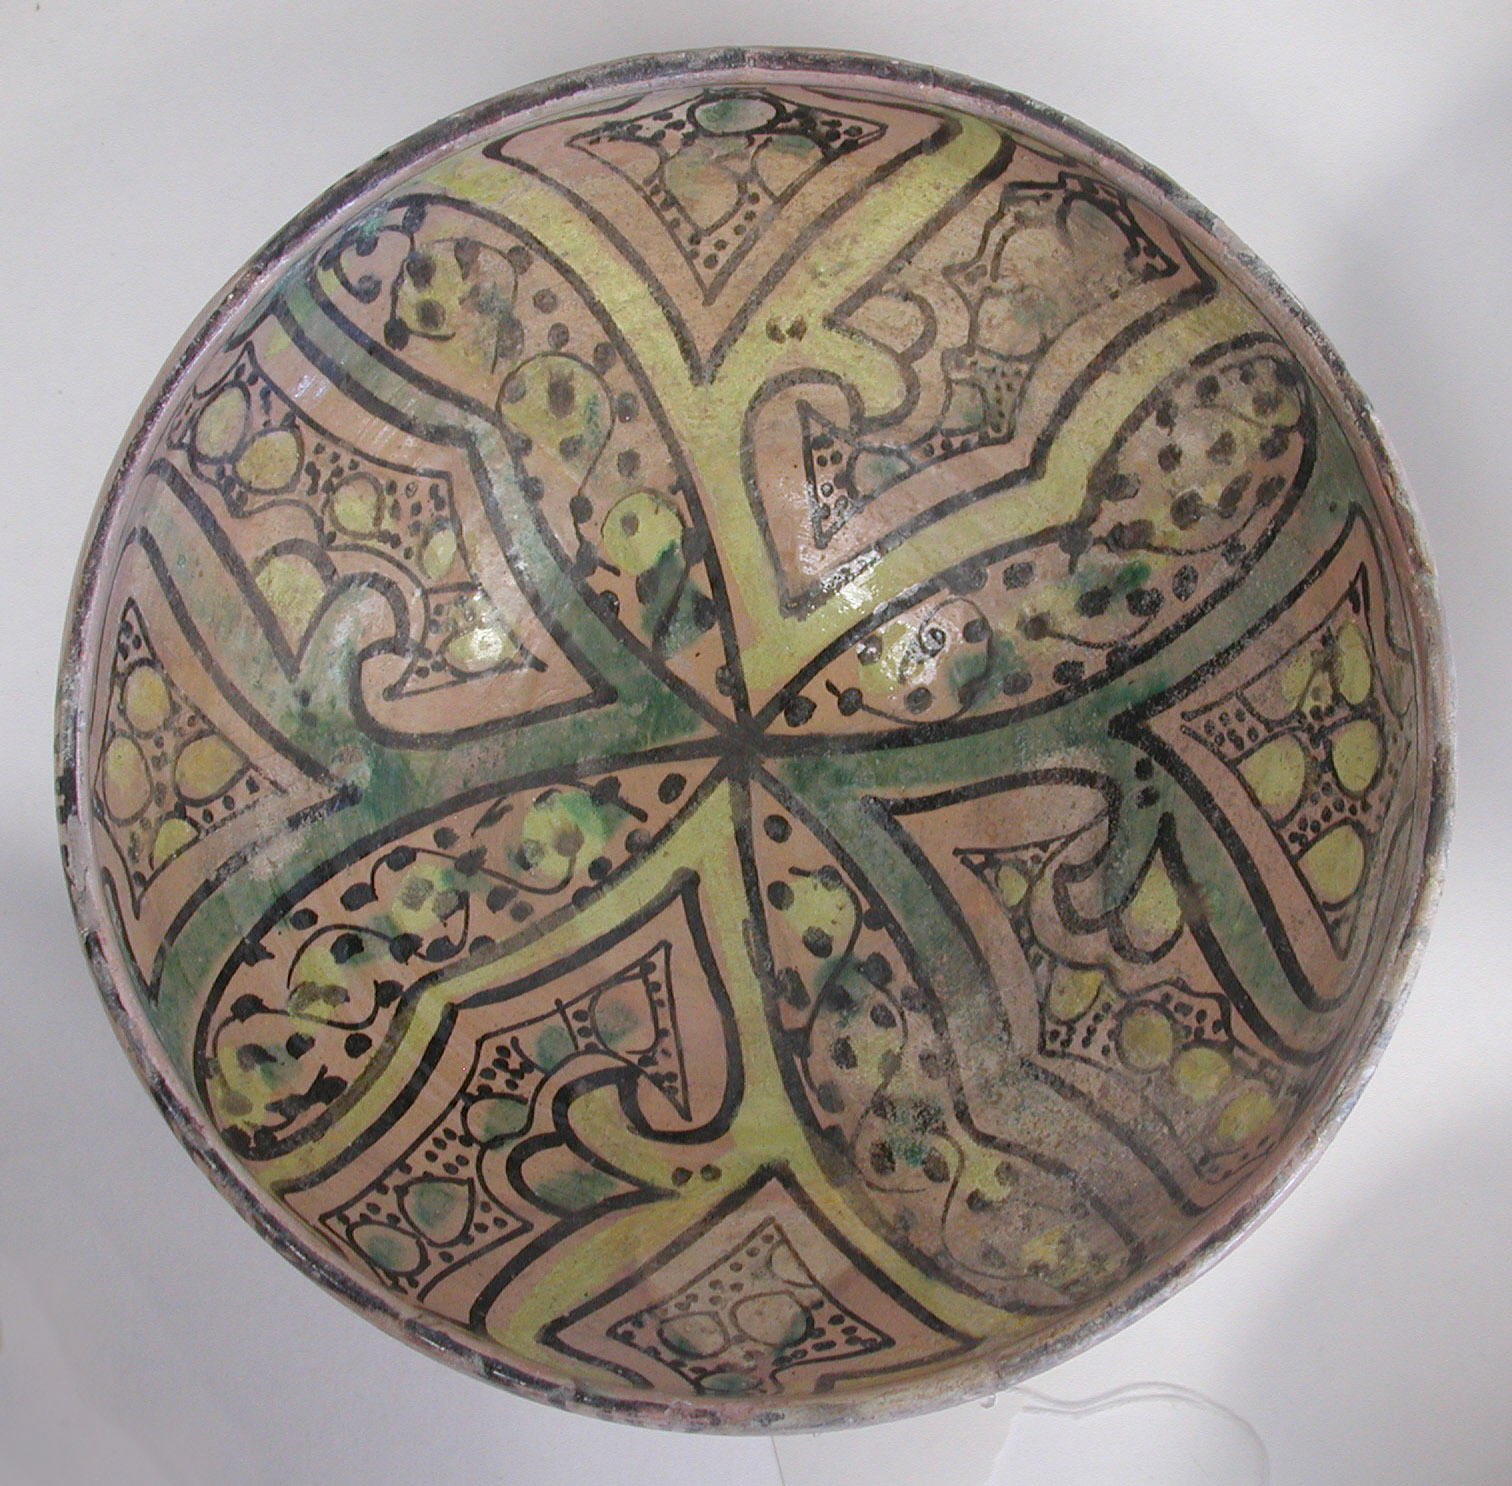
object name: bowl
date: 801-900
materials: earthenware, glaze, pigment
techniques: painting, polychrome, underglaze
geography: iran